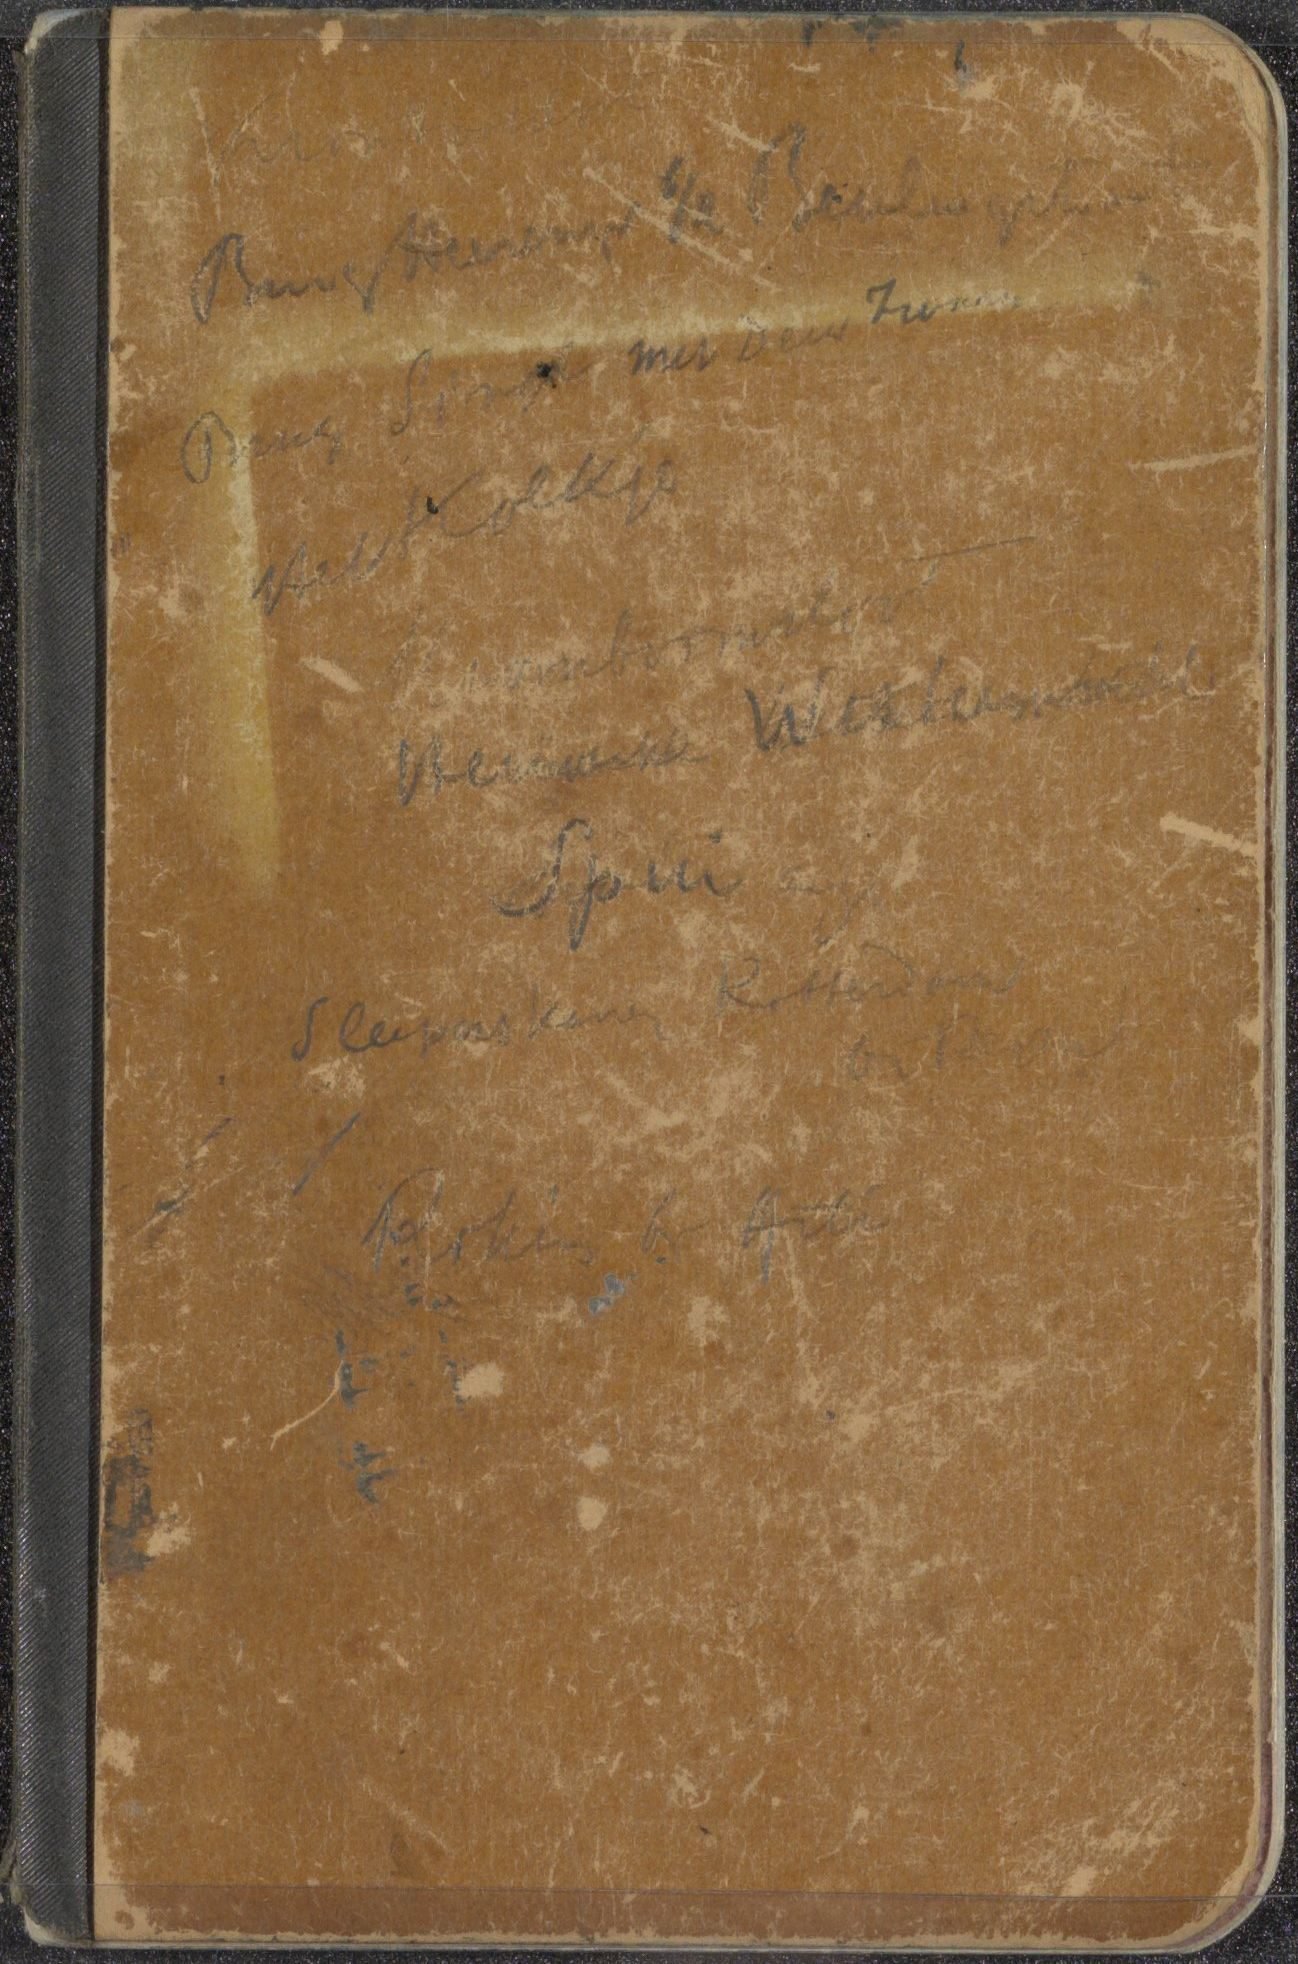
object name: sketchbook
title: Schetsboek met 42 bladen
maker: george hendrik breitner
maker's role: draughtsman, painter, print maker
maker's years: 1857-1923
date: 1898-1902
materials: cardboard, chalk, linen, paper, pencil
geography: amsterdam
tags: street, amsterdam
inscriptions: annotation: ‘Kromboomsloot[?] [ sic]/ Brug Heerengr b/d Beulingstraat/ Brug Singel met Deur Zwaan/ Het Kolkje/ Kromboomsloot[?]/ Heiwerken Westermarkt / Spui/ Sleeperskarren Rotterdam/ bij regen/ Rokin bij Arti’, number: ‘5’, collector's mark: Lugt 2228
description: Schetsboek met 42 bladen met gezichten te Amsterdam en figuurstudies.